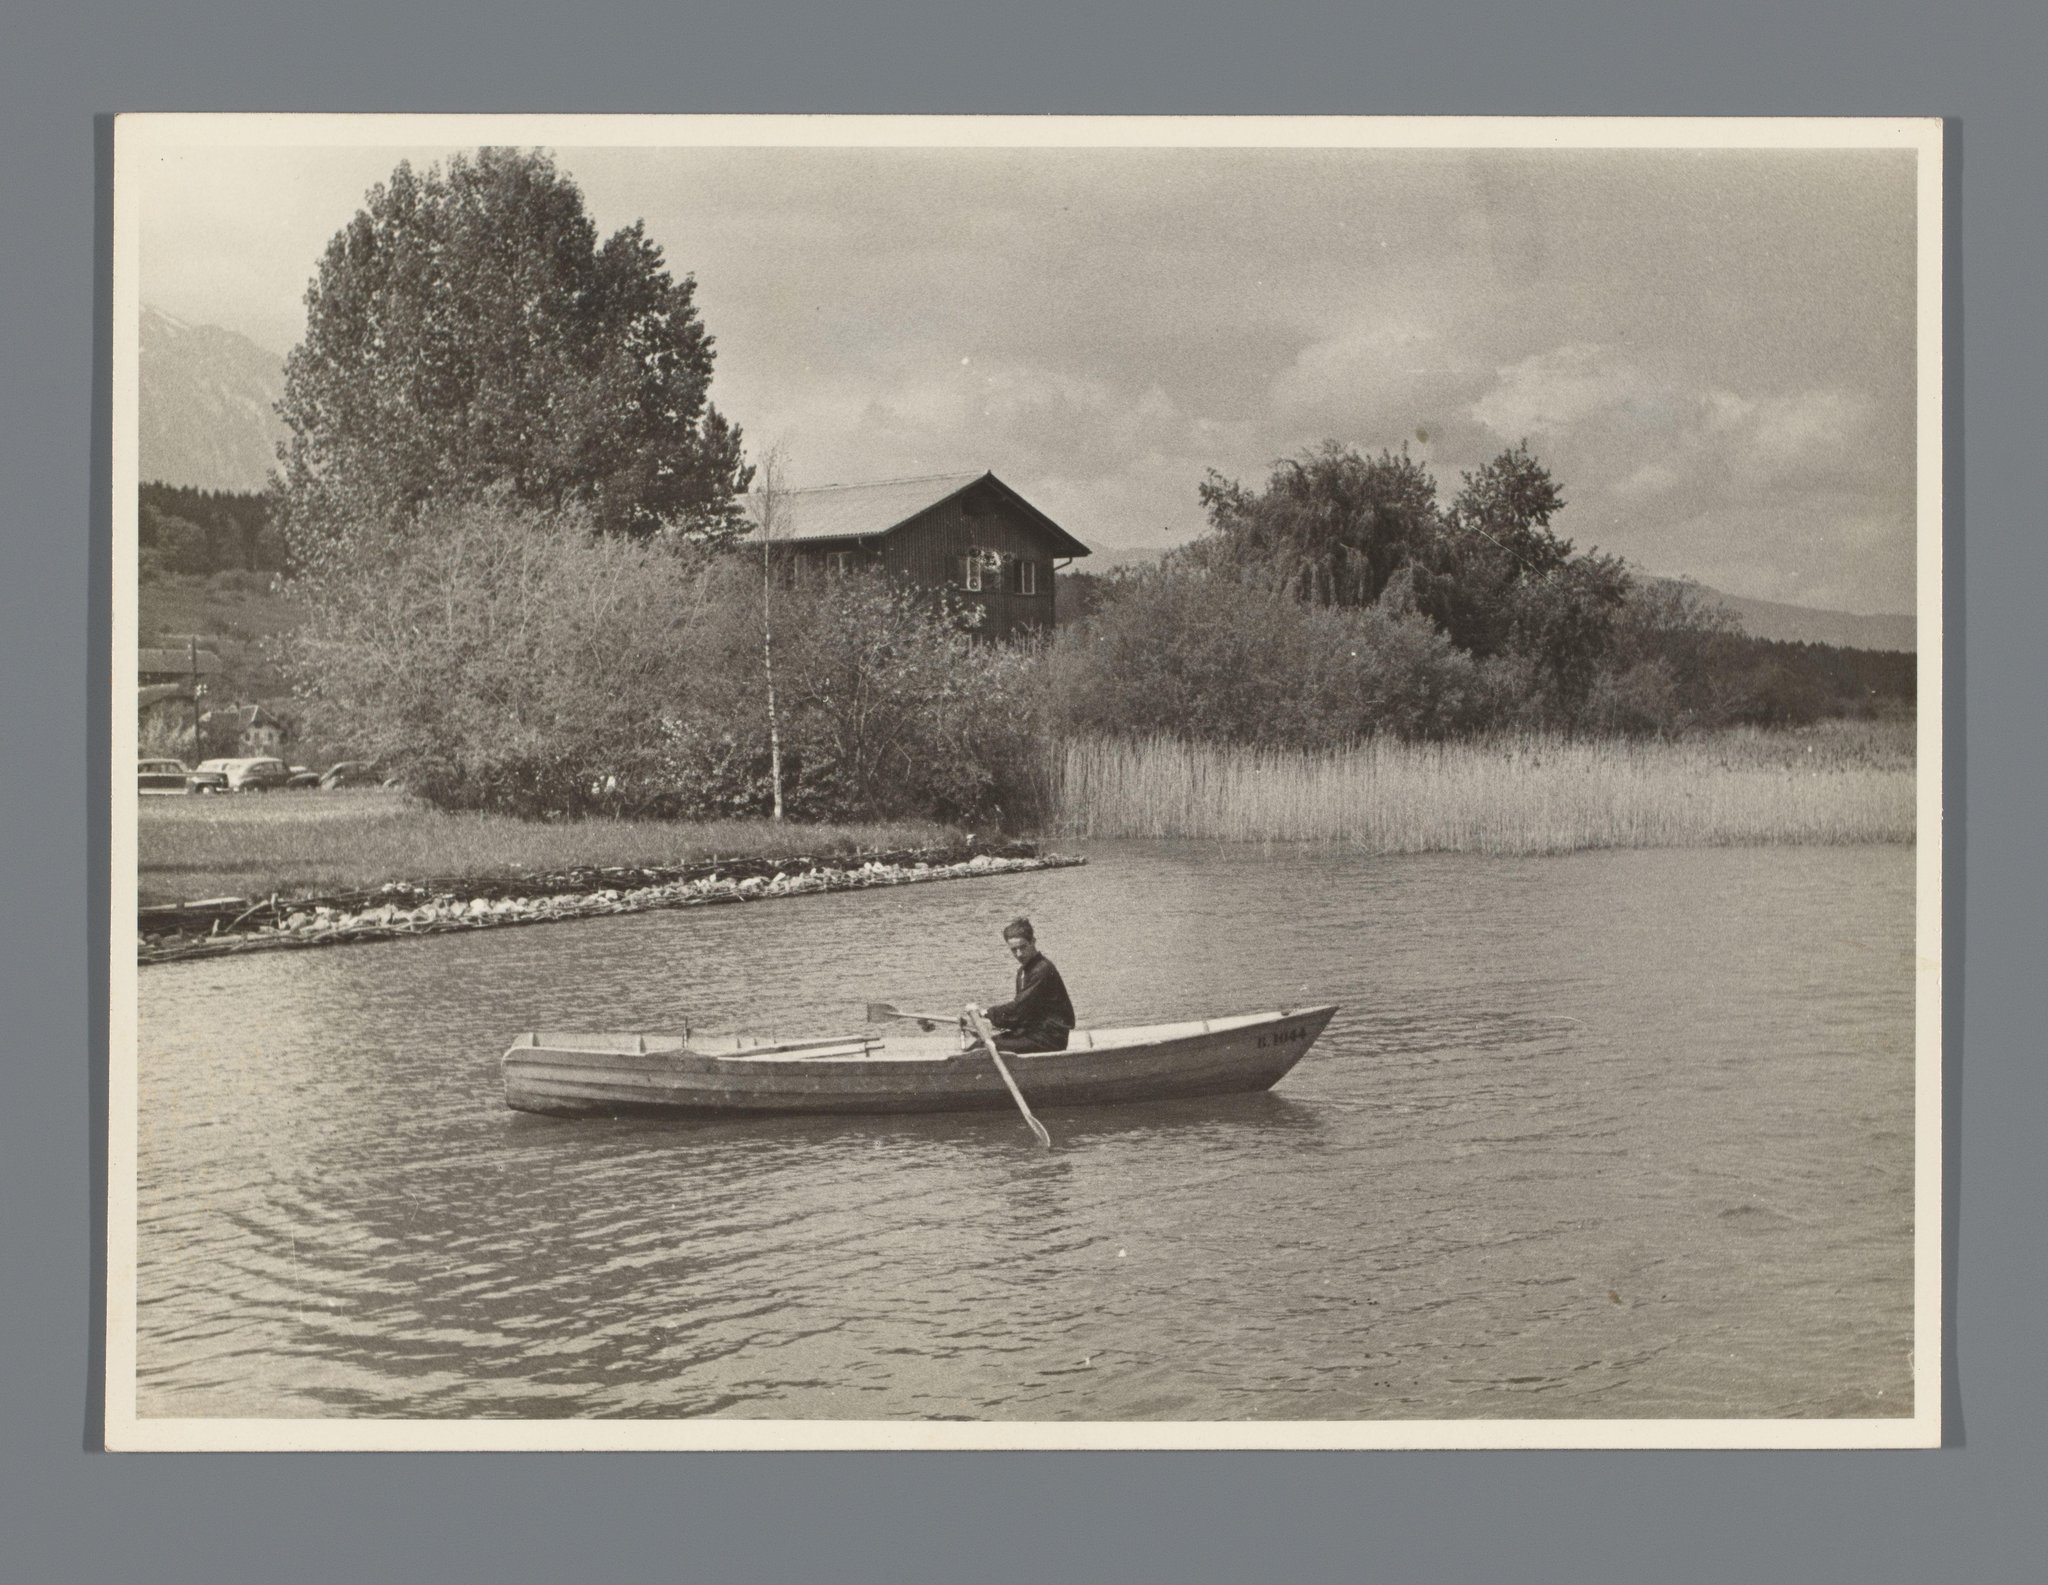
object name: photograph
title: Landschap in zwart-wit met een jonge man in een roeiboot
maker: Anonymous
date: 1900-1920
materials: photographic support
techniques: gelatin silver print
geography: united states